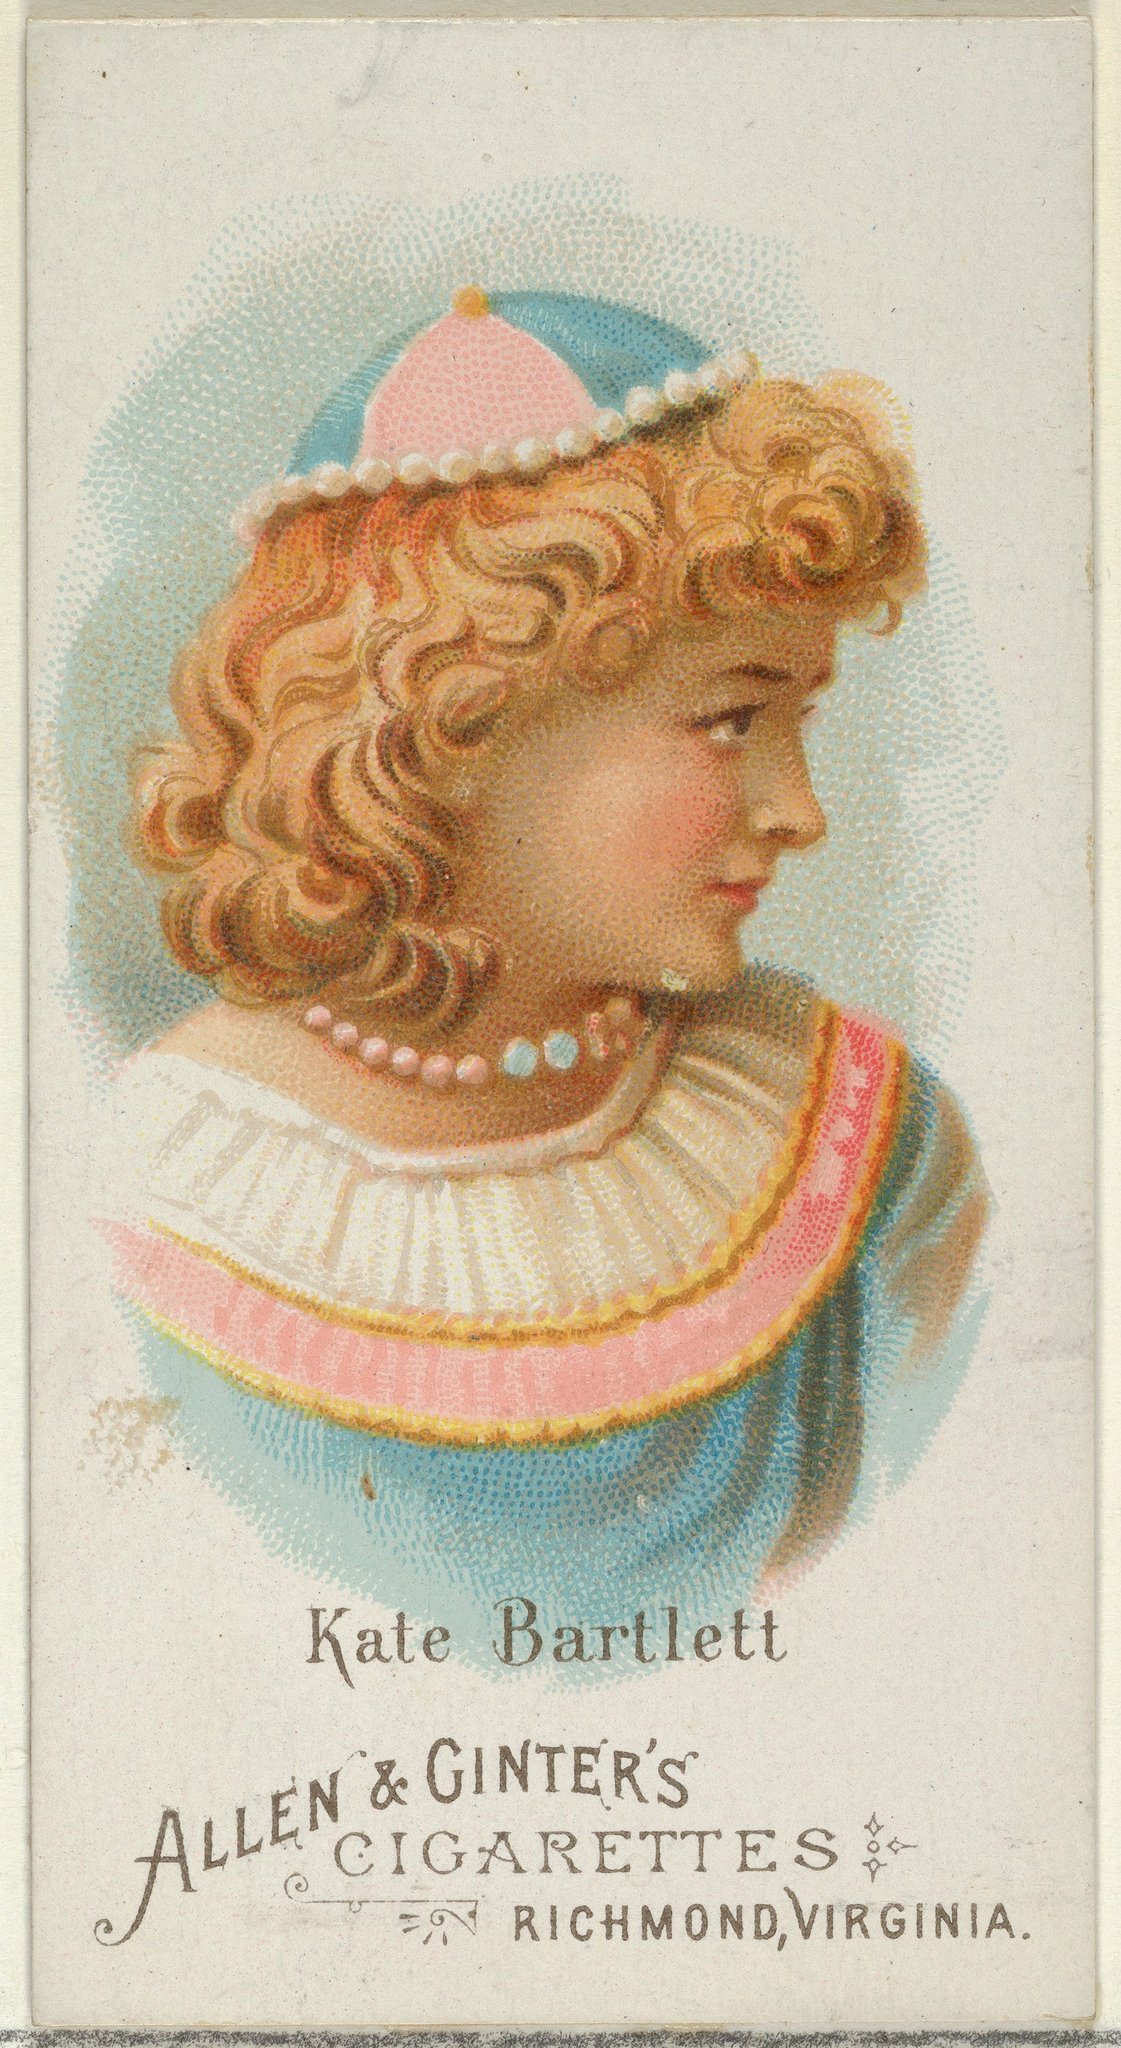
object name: print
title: Kate Bartlett, from World's Beauties, Series 1 (N26) for Allen & Ginter Cigarettes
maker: allen & ginter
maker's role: publisher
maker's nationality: american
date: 1888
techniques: color lithograph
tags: women